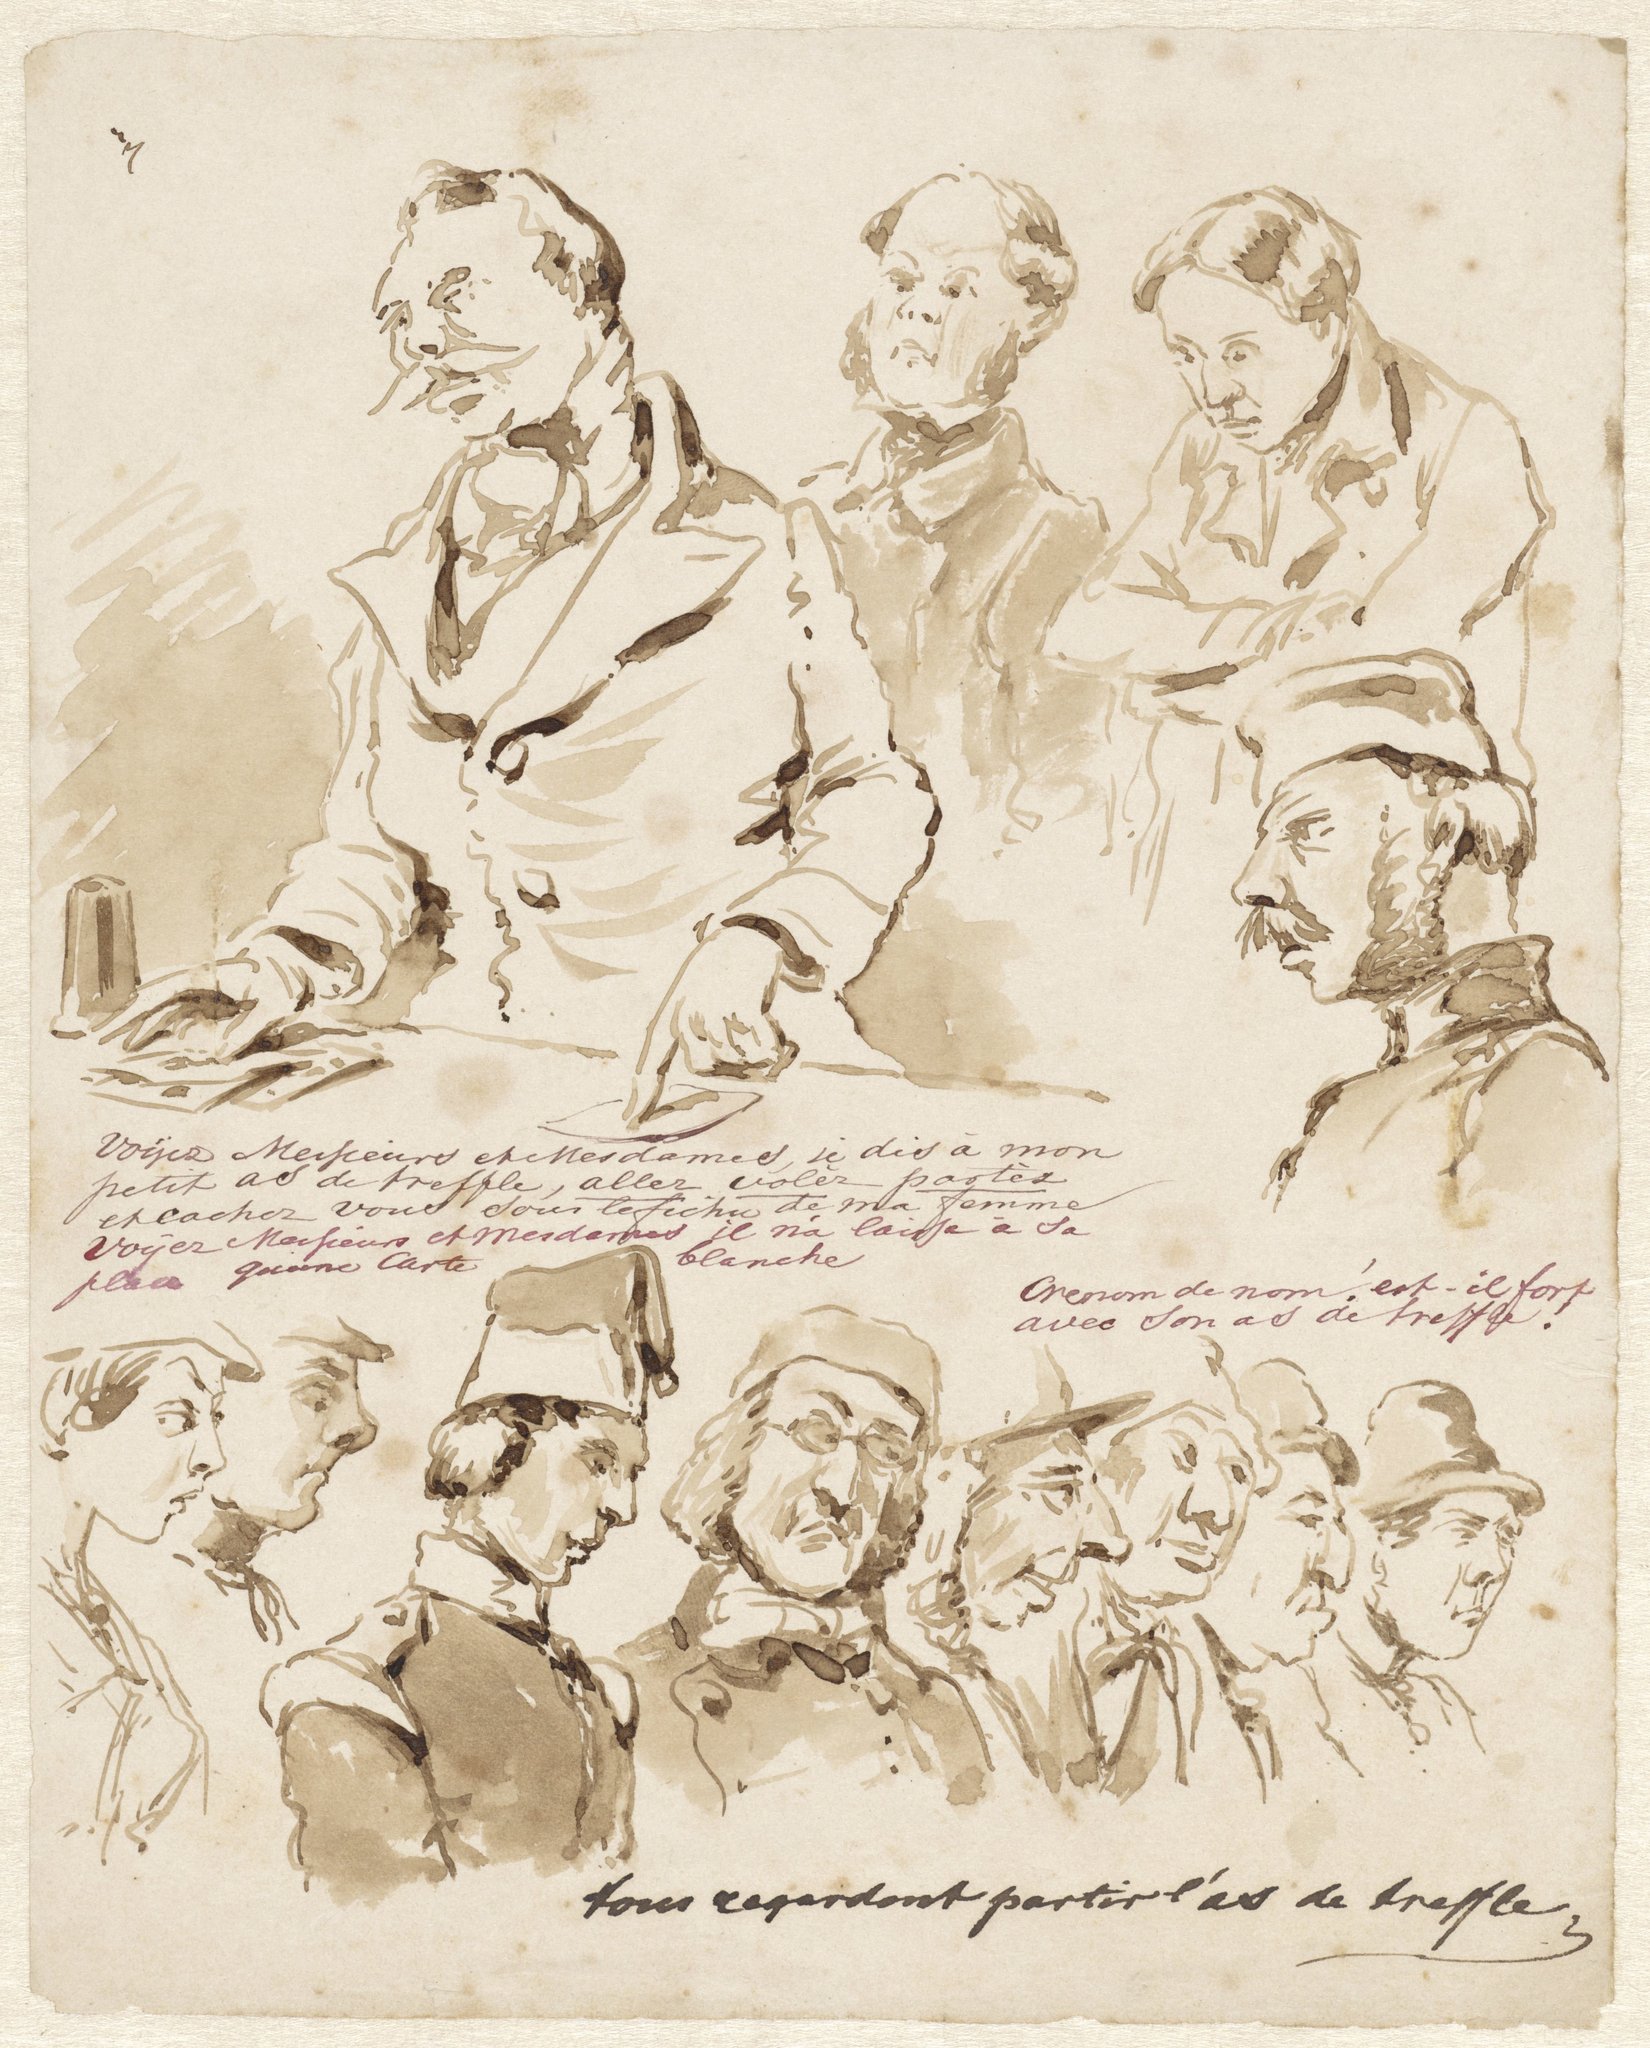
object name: drawing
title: Karikaturale voorstelling van een goochelaar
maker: pieter van loon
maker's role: draughtsman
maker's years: 1801-1873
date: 1811-1873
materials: paper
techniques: brush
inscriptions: date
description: Karikaturale voorstelling van een goochelaar met kaarten en zijn publiek. Met bijschriften in het midden en rechtsonder: voijez Messieurs et Mesdames....